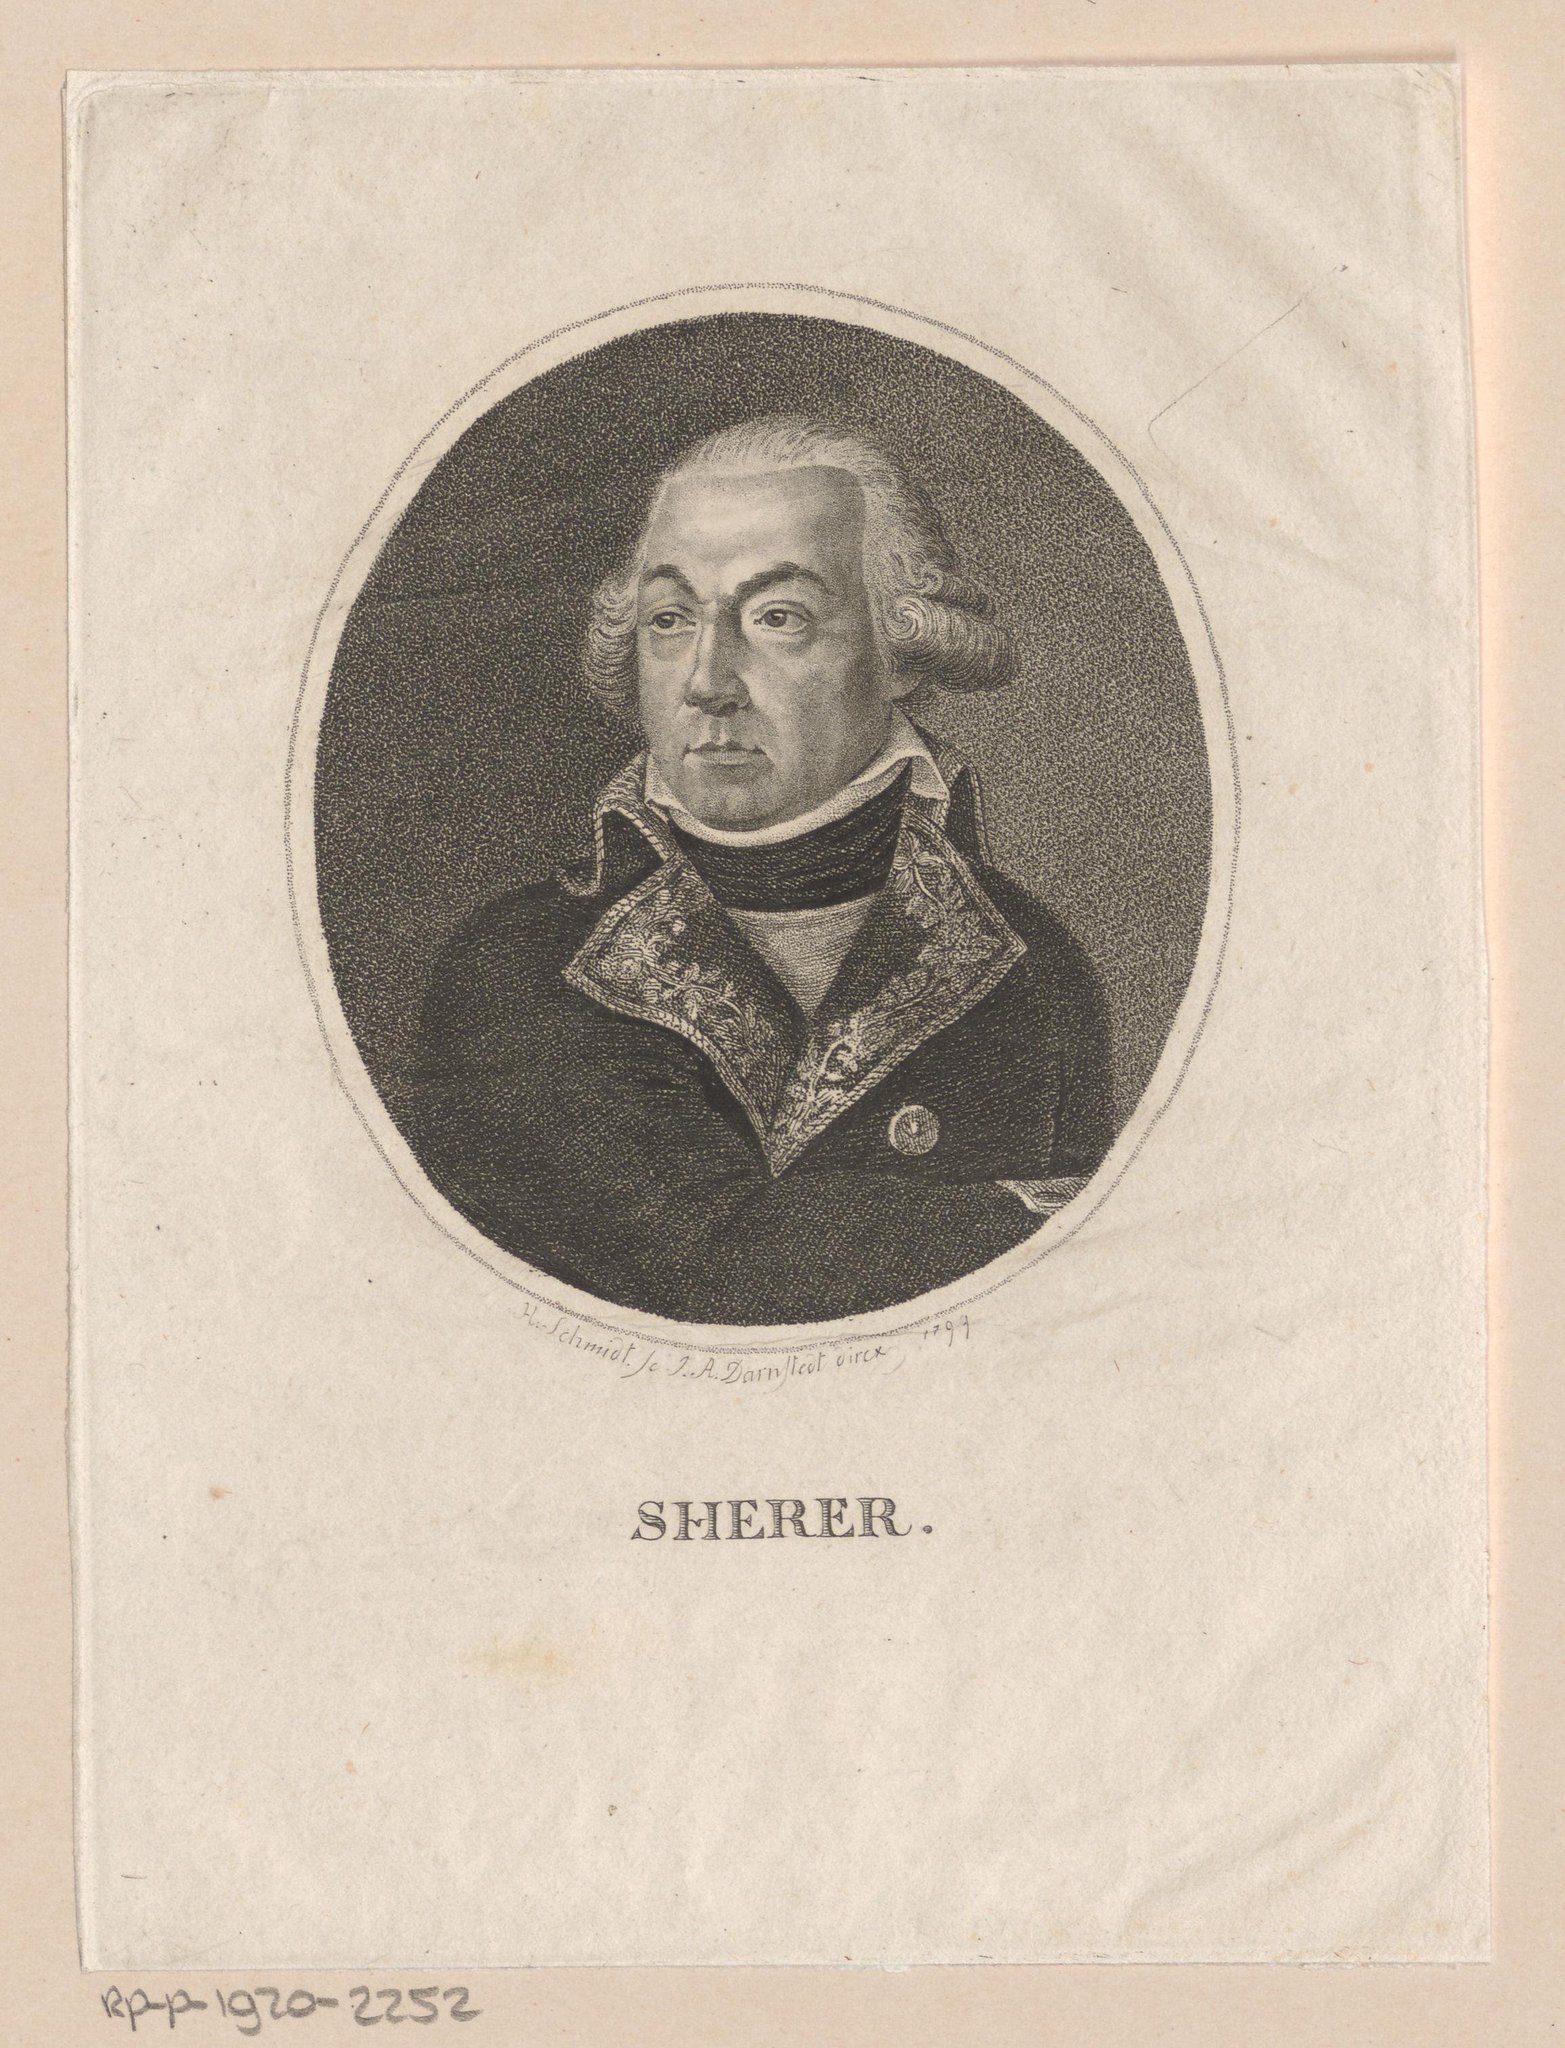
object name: print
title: Portret van Barthélemy Louis Joseph Schérer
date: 1799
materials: paper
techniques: etching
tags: commander-in-chief, general, marshal, historical persons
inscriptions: collector's mark: Lugt 2228